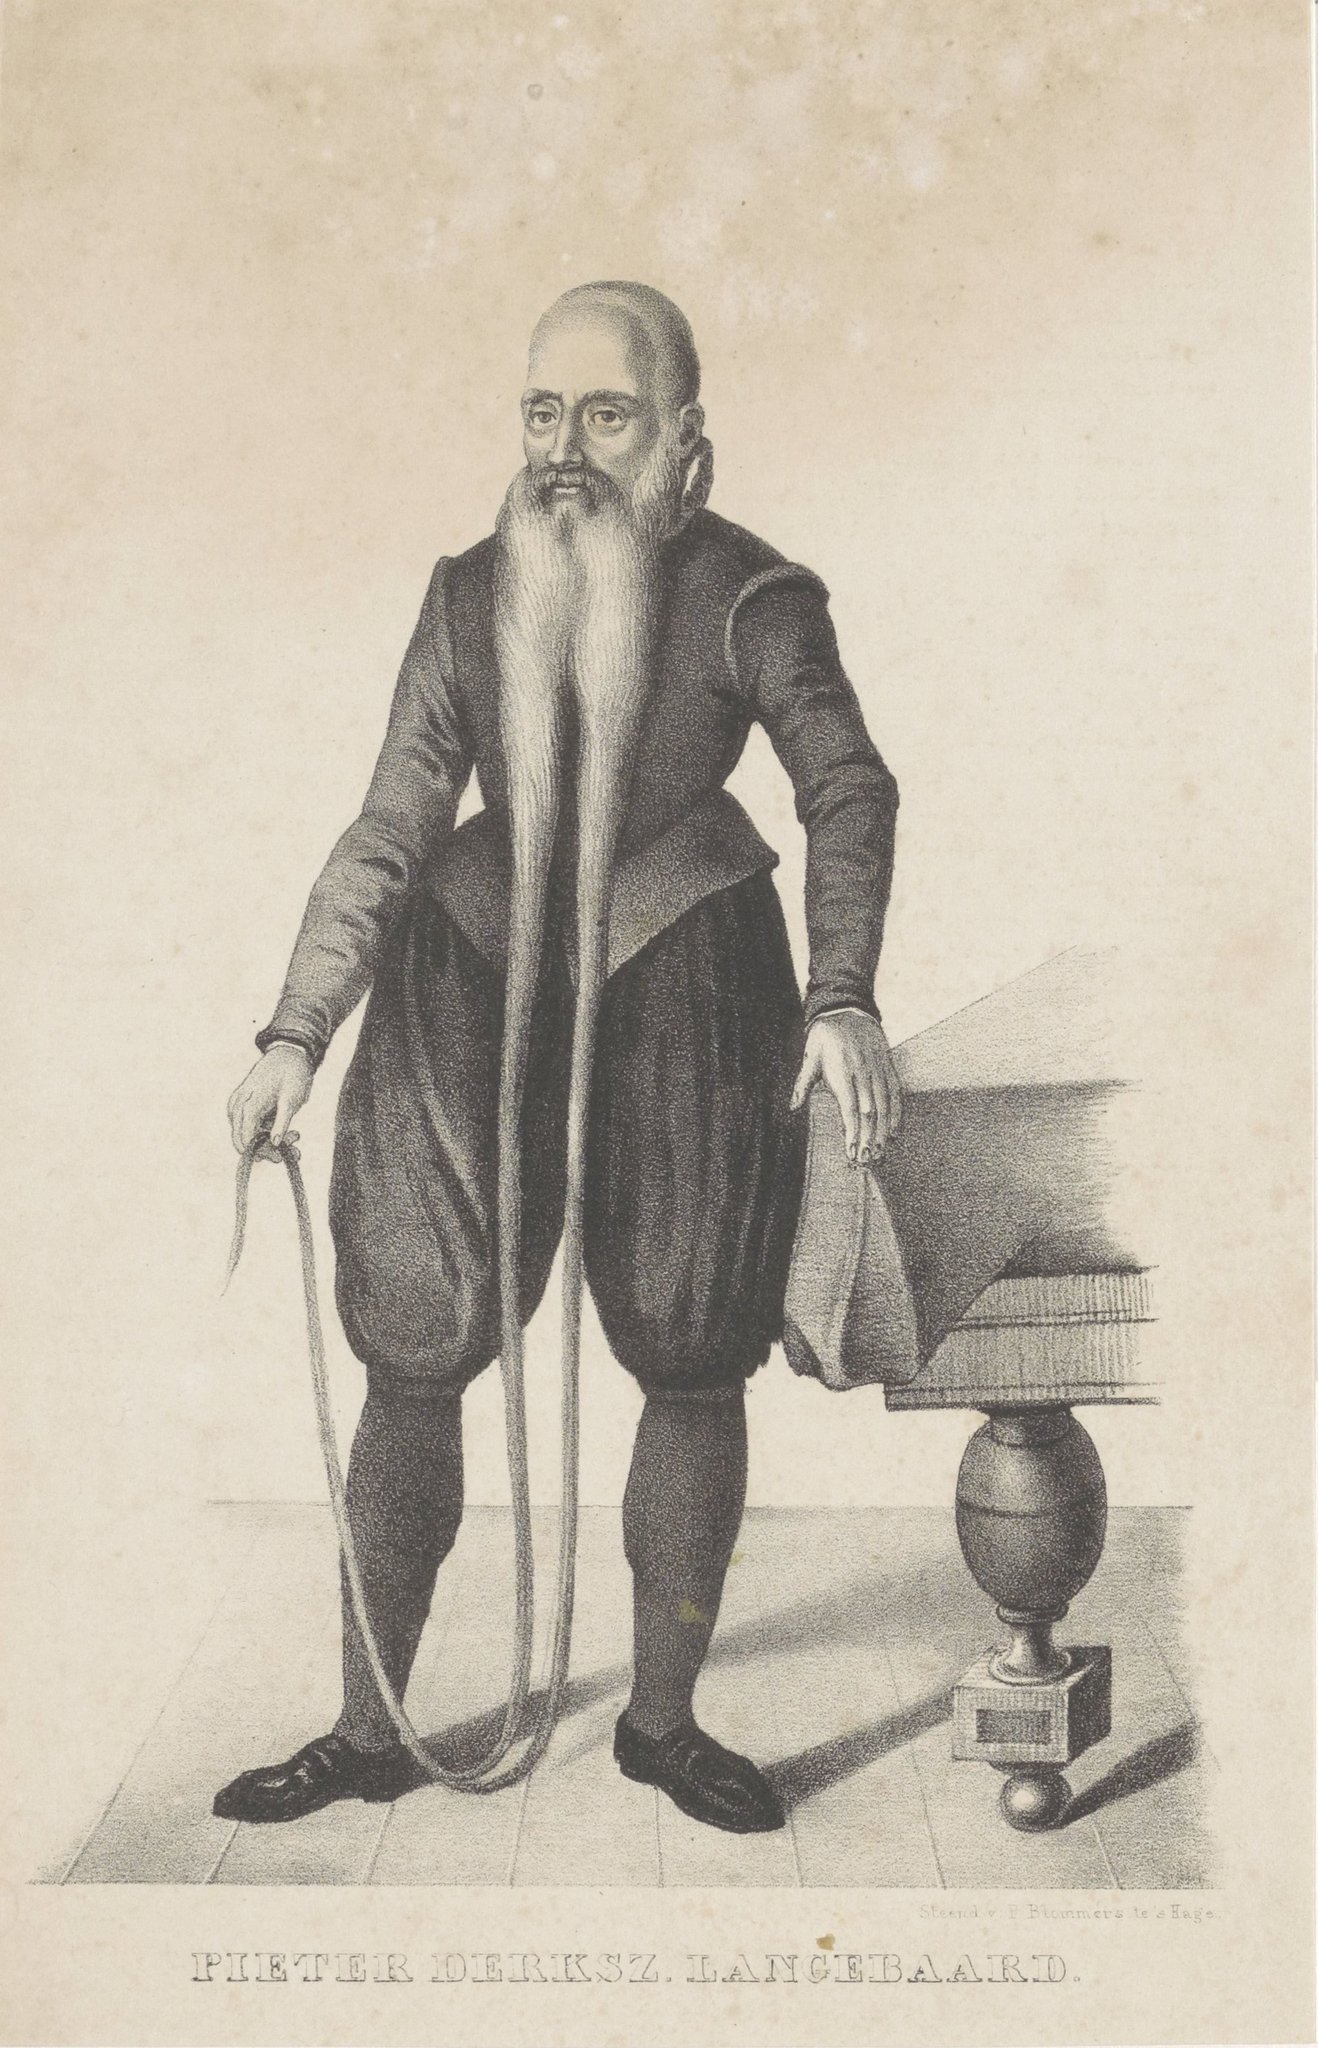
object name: print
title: Portret van Pieter Derksz. Langebaard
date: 1842-1887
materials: paper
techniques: lithograph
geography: the hague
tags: beard, historical persons (+ full length portrait)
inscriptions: collector's mark: Lugt 2228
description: De man is ten voeten uit afgebeeld naast een tafel. Hij heeft een lange baard, verdeeld in twee stukken. Het uiteinde ervan houdt hij in zijn rechterhand.